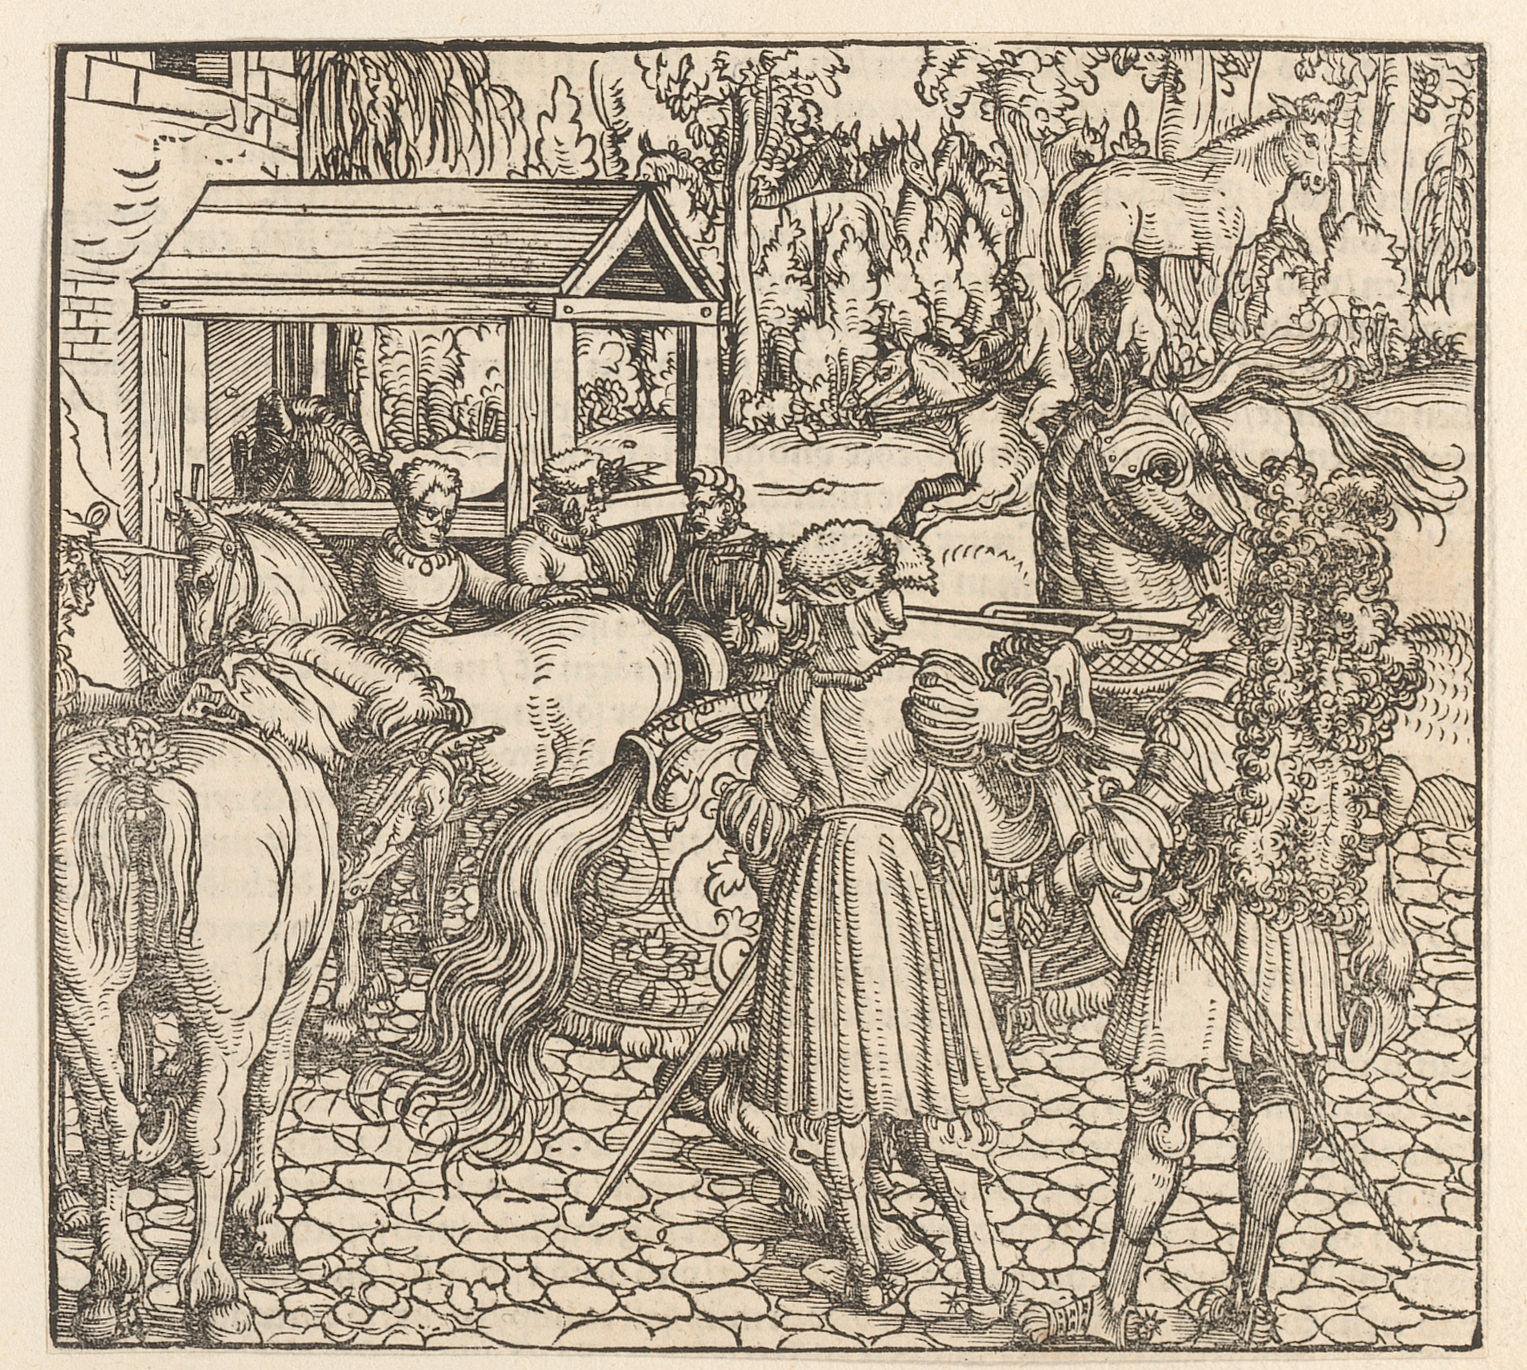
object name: print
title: Ridders bij een stoeterij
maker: Anonymous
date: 1514-1532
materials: paper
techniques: letterpress printing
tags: riding a horse, ass, or mule; rider, horseman, stud farm, knight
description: Deze prent is gebruikt in: Petrarca, Francesco. Von der Artzney bayder Glück, des guten und widerwertigen: unnd weß sich ain yeder inn Gelück und Unglück halten sol (...). Augsburg: Heinrich Steiner, 1532. Deze uitgave is ook bekend onder de titel 'Trostspiegel in Glück und Unglück'.